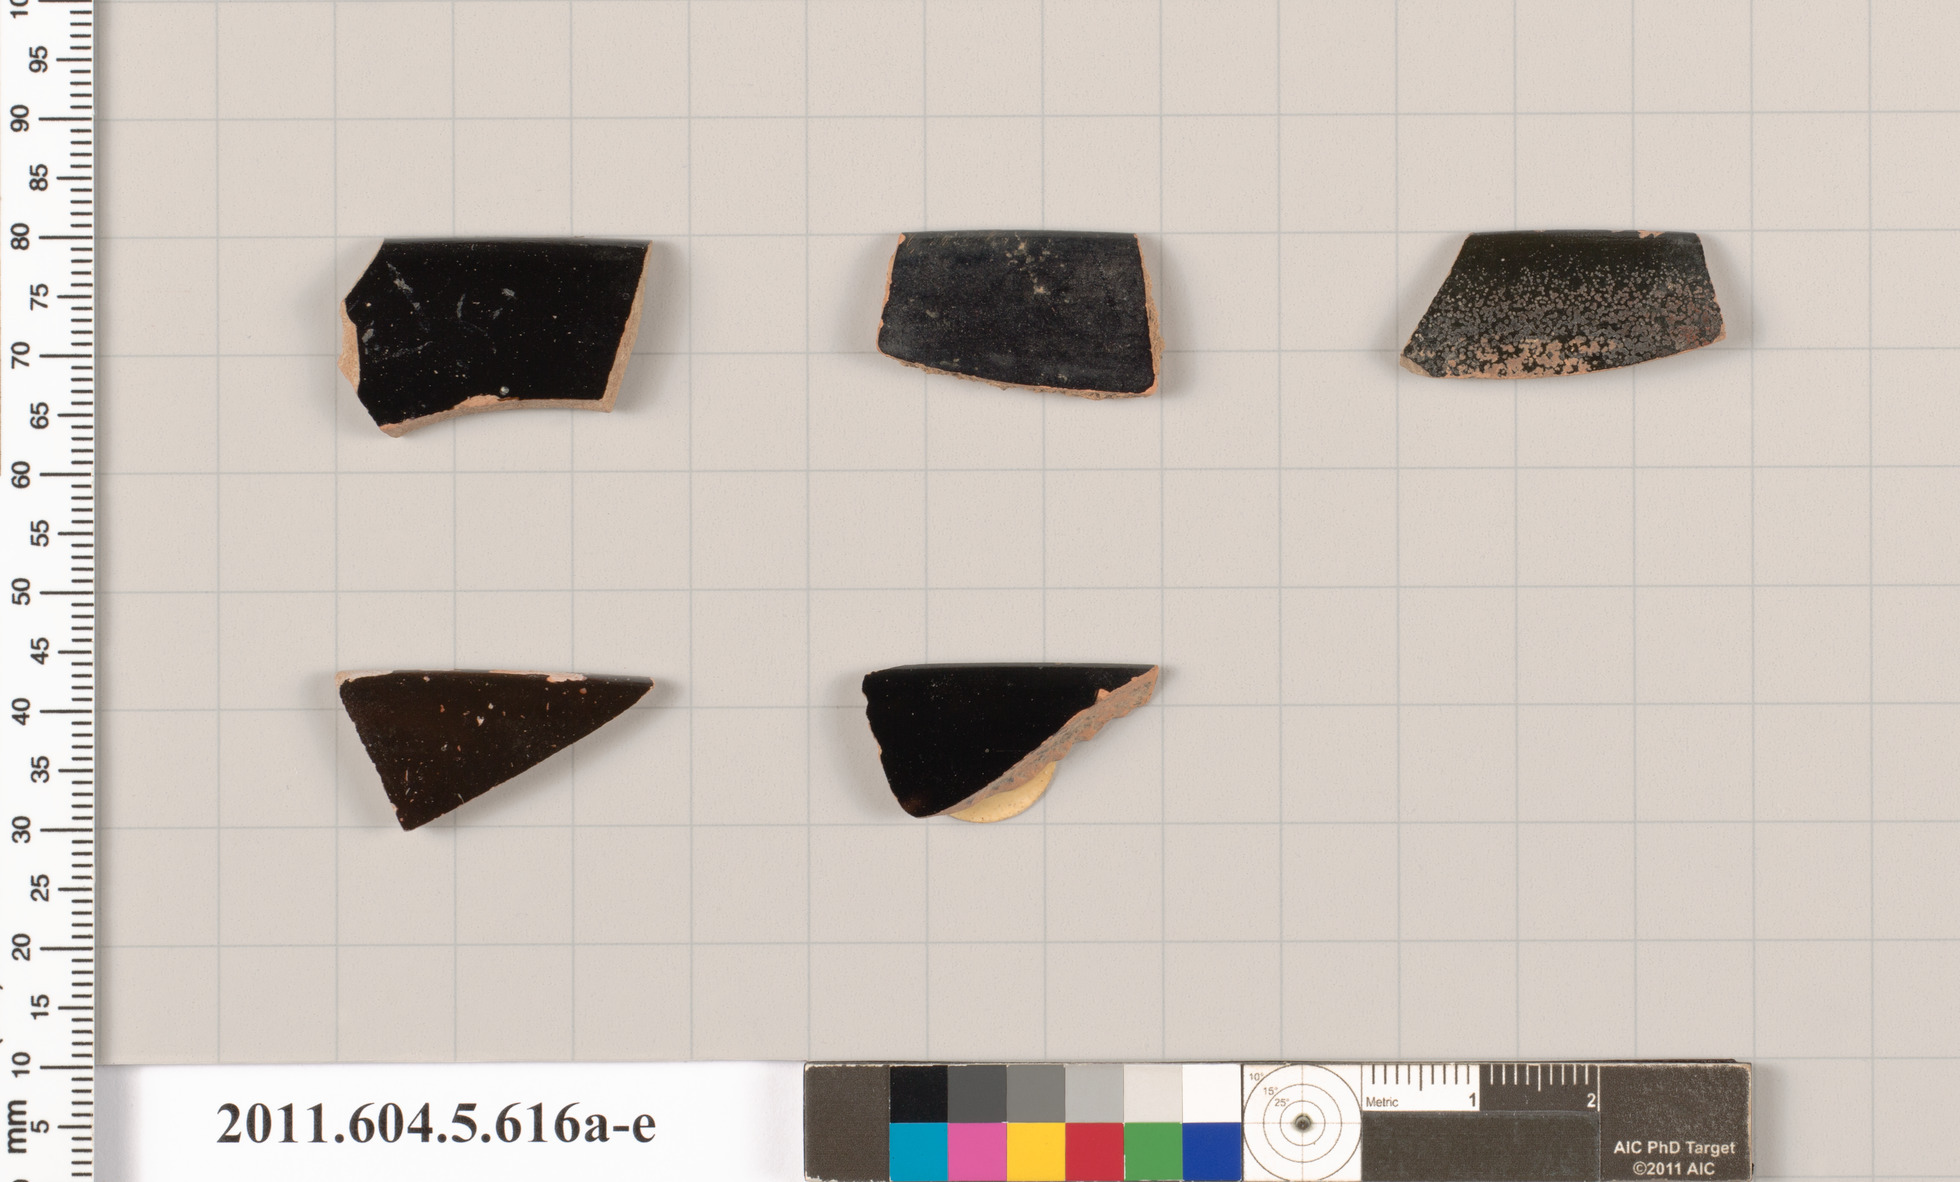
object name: kylix fragment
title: Terracotta rim fragments of kylikes (drinking cups)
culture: greek, attic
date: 600-401 BCE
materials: terracotta